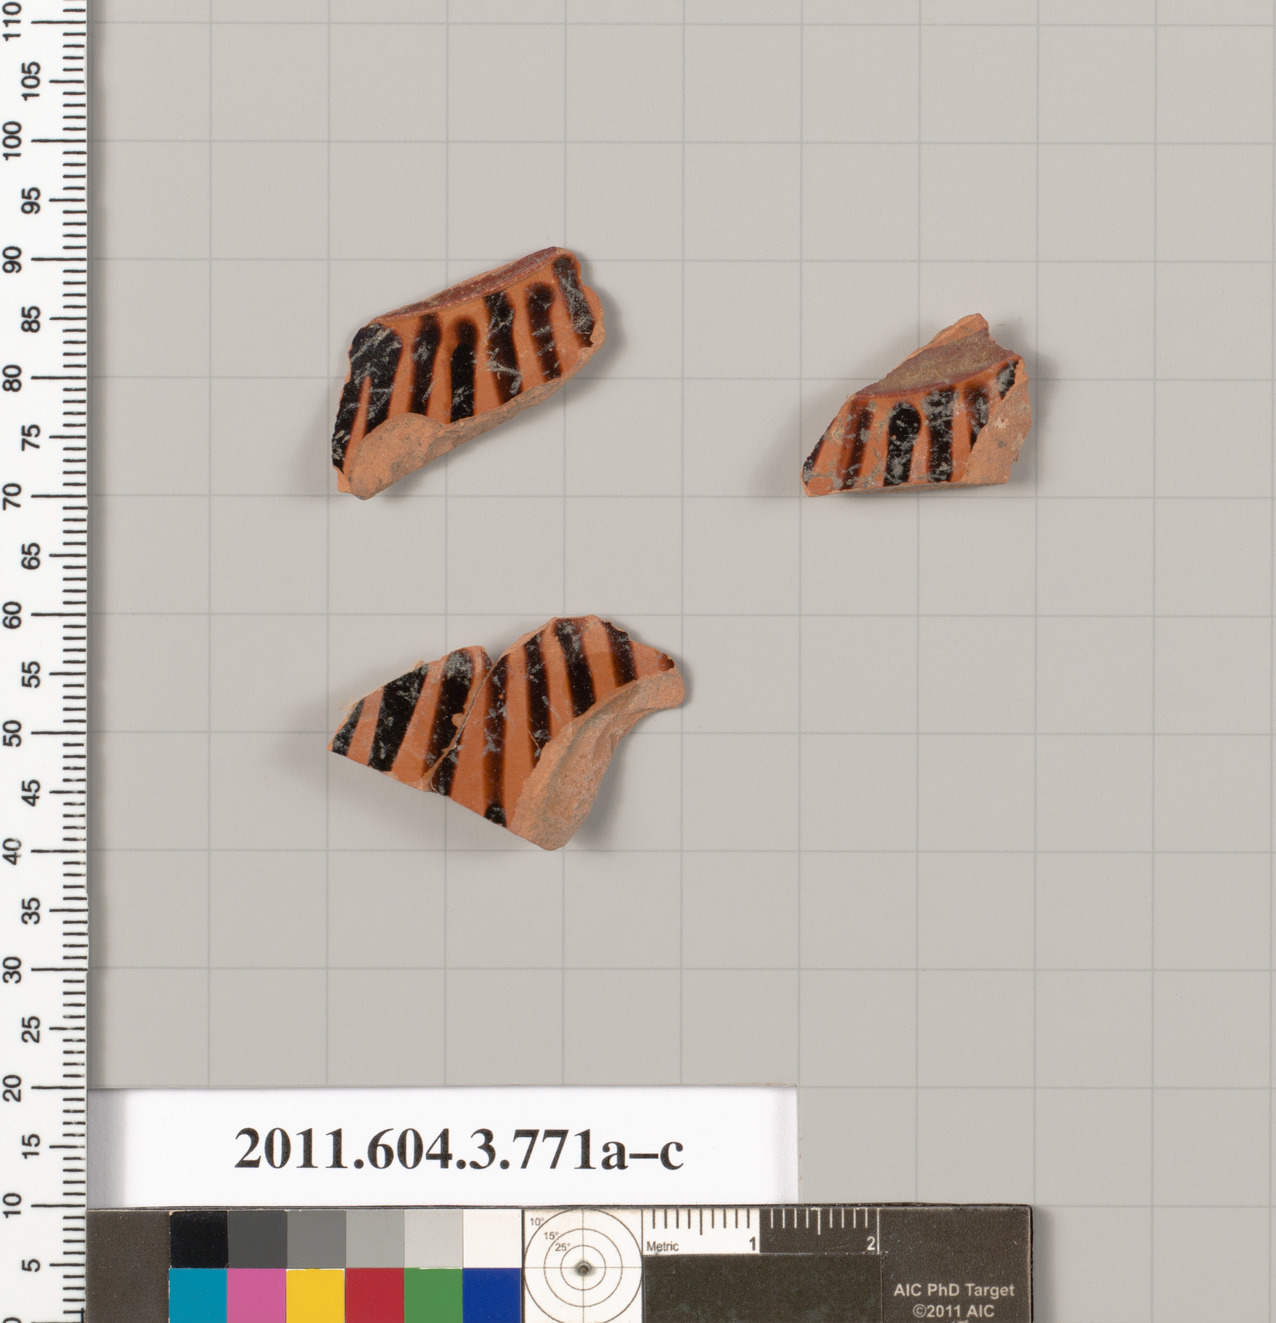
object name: oinochoe fragment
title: Terracotta fragments of oinochoai (jugs)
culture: greek, attic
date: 534-468 BCE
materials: terracotta